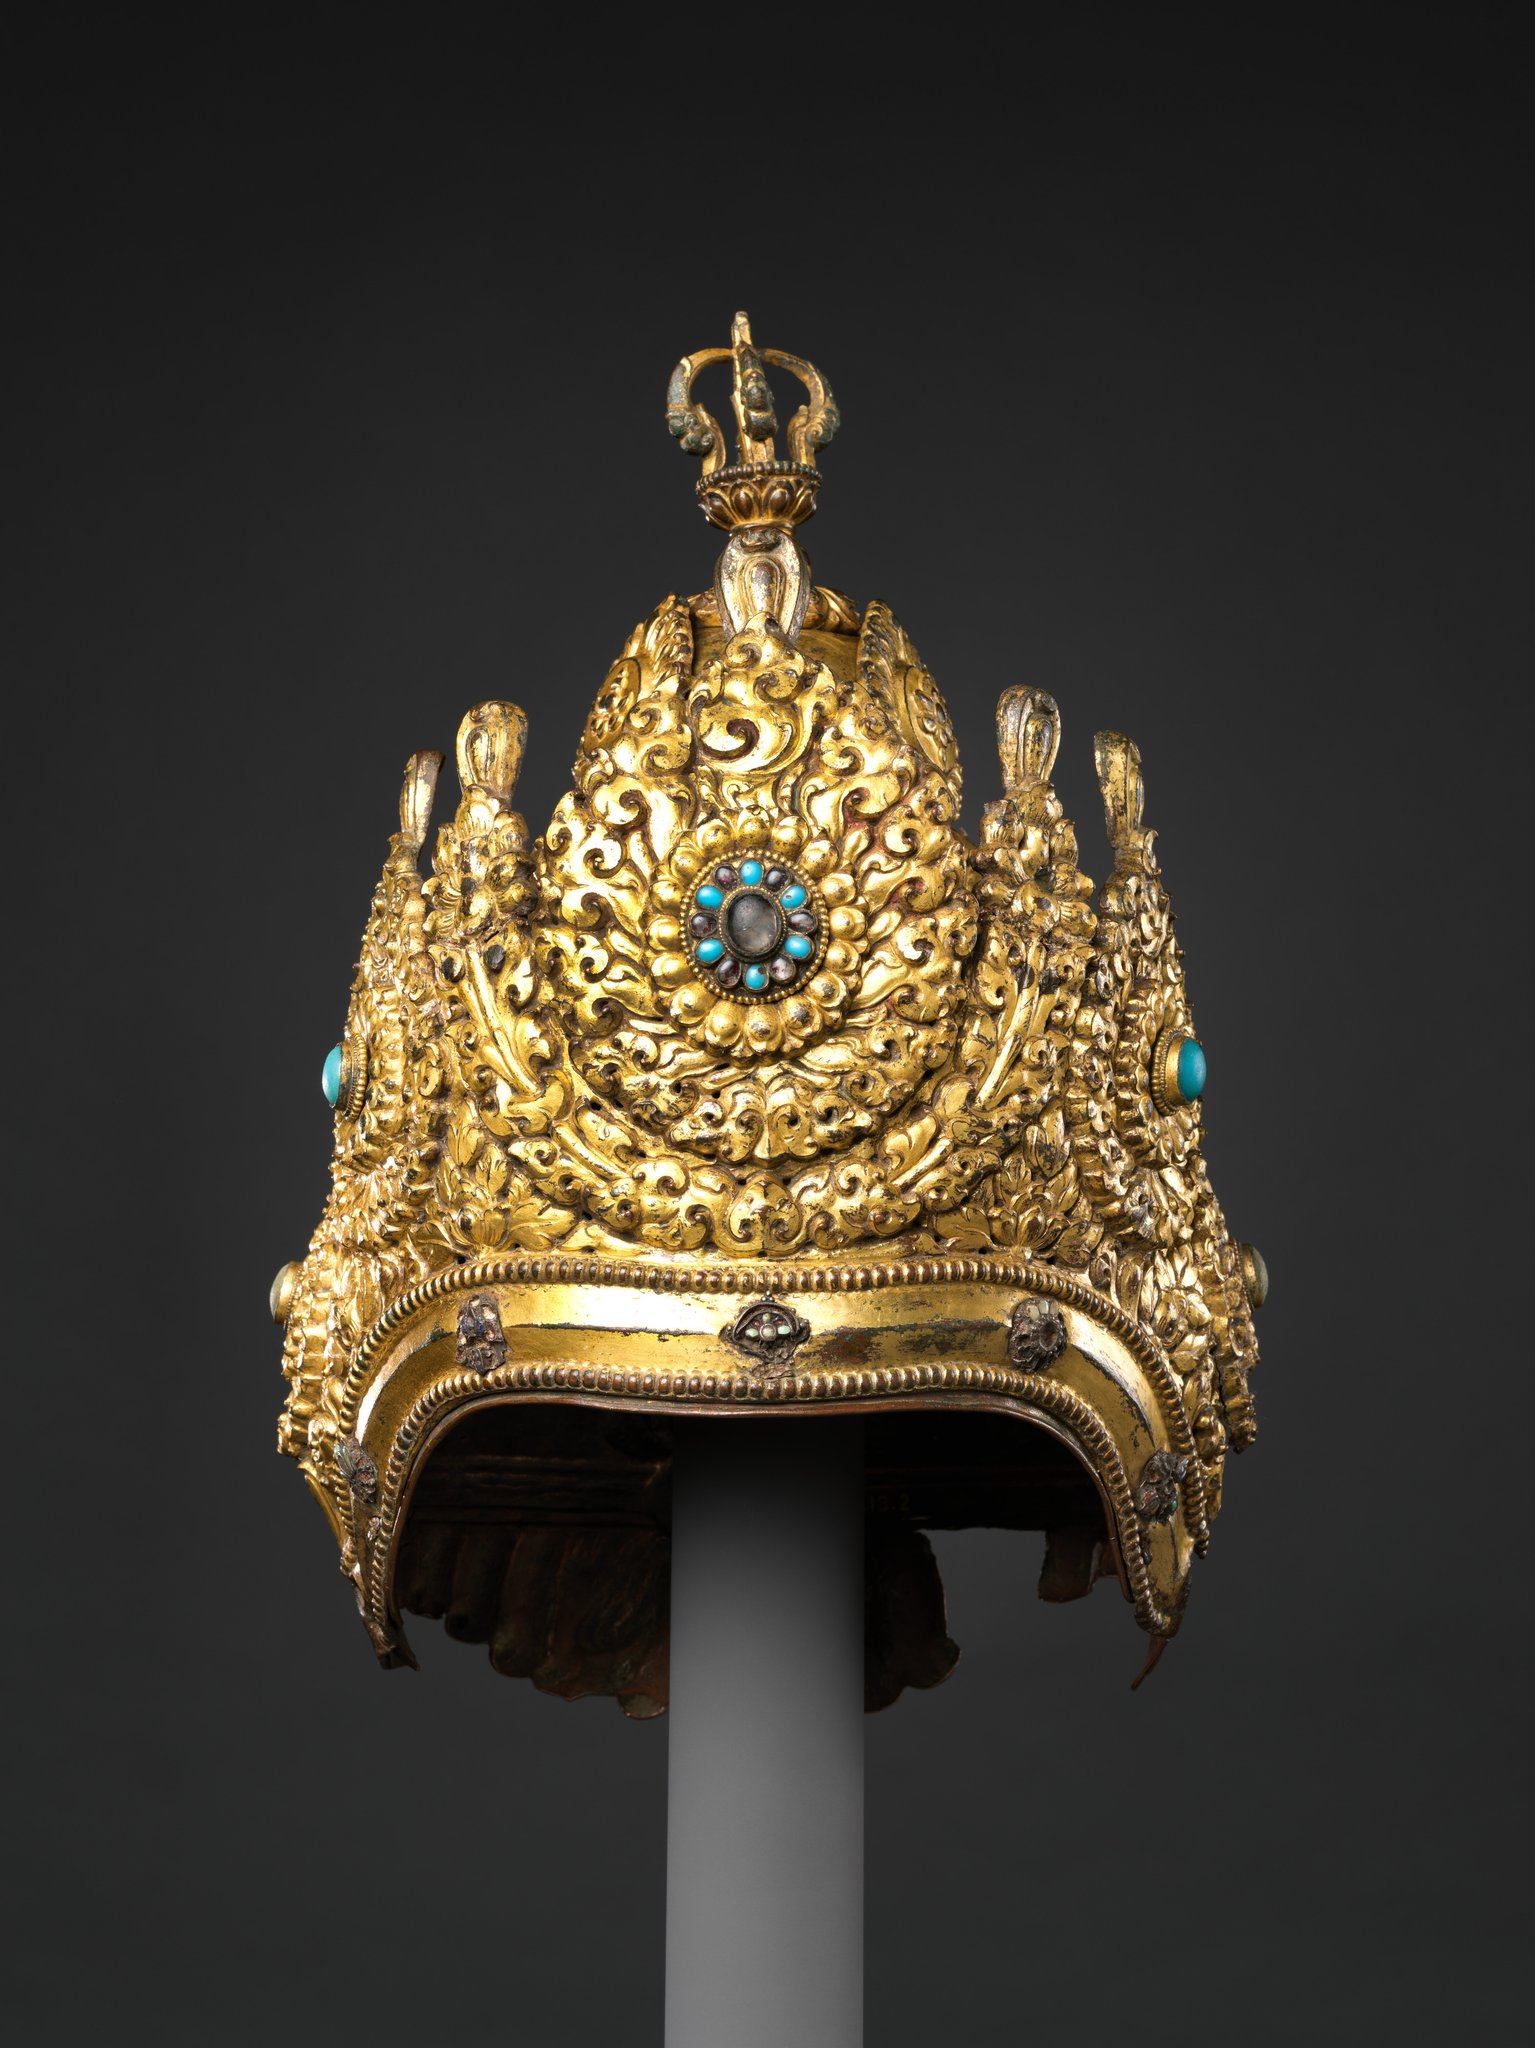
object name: ritual crown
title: Vajracharya Priest’s Crown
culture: nepali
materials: copper alloy, gilt, stone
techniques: inlay